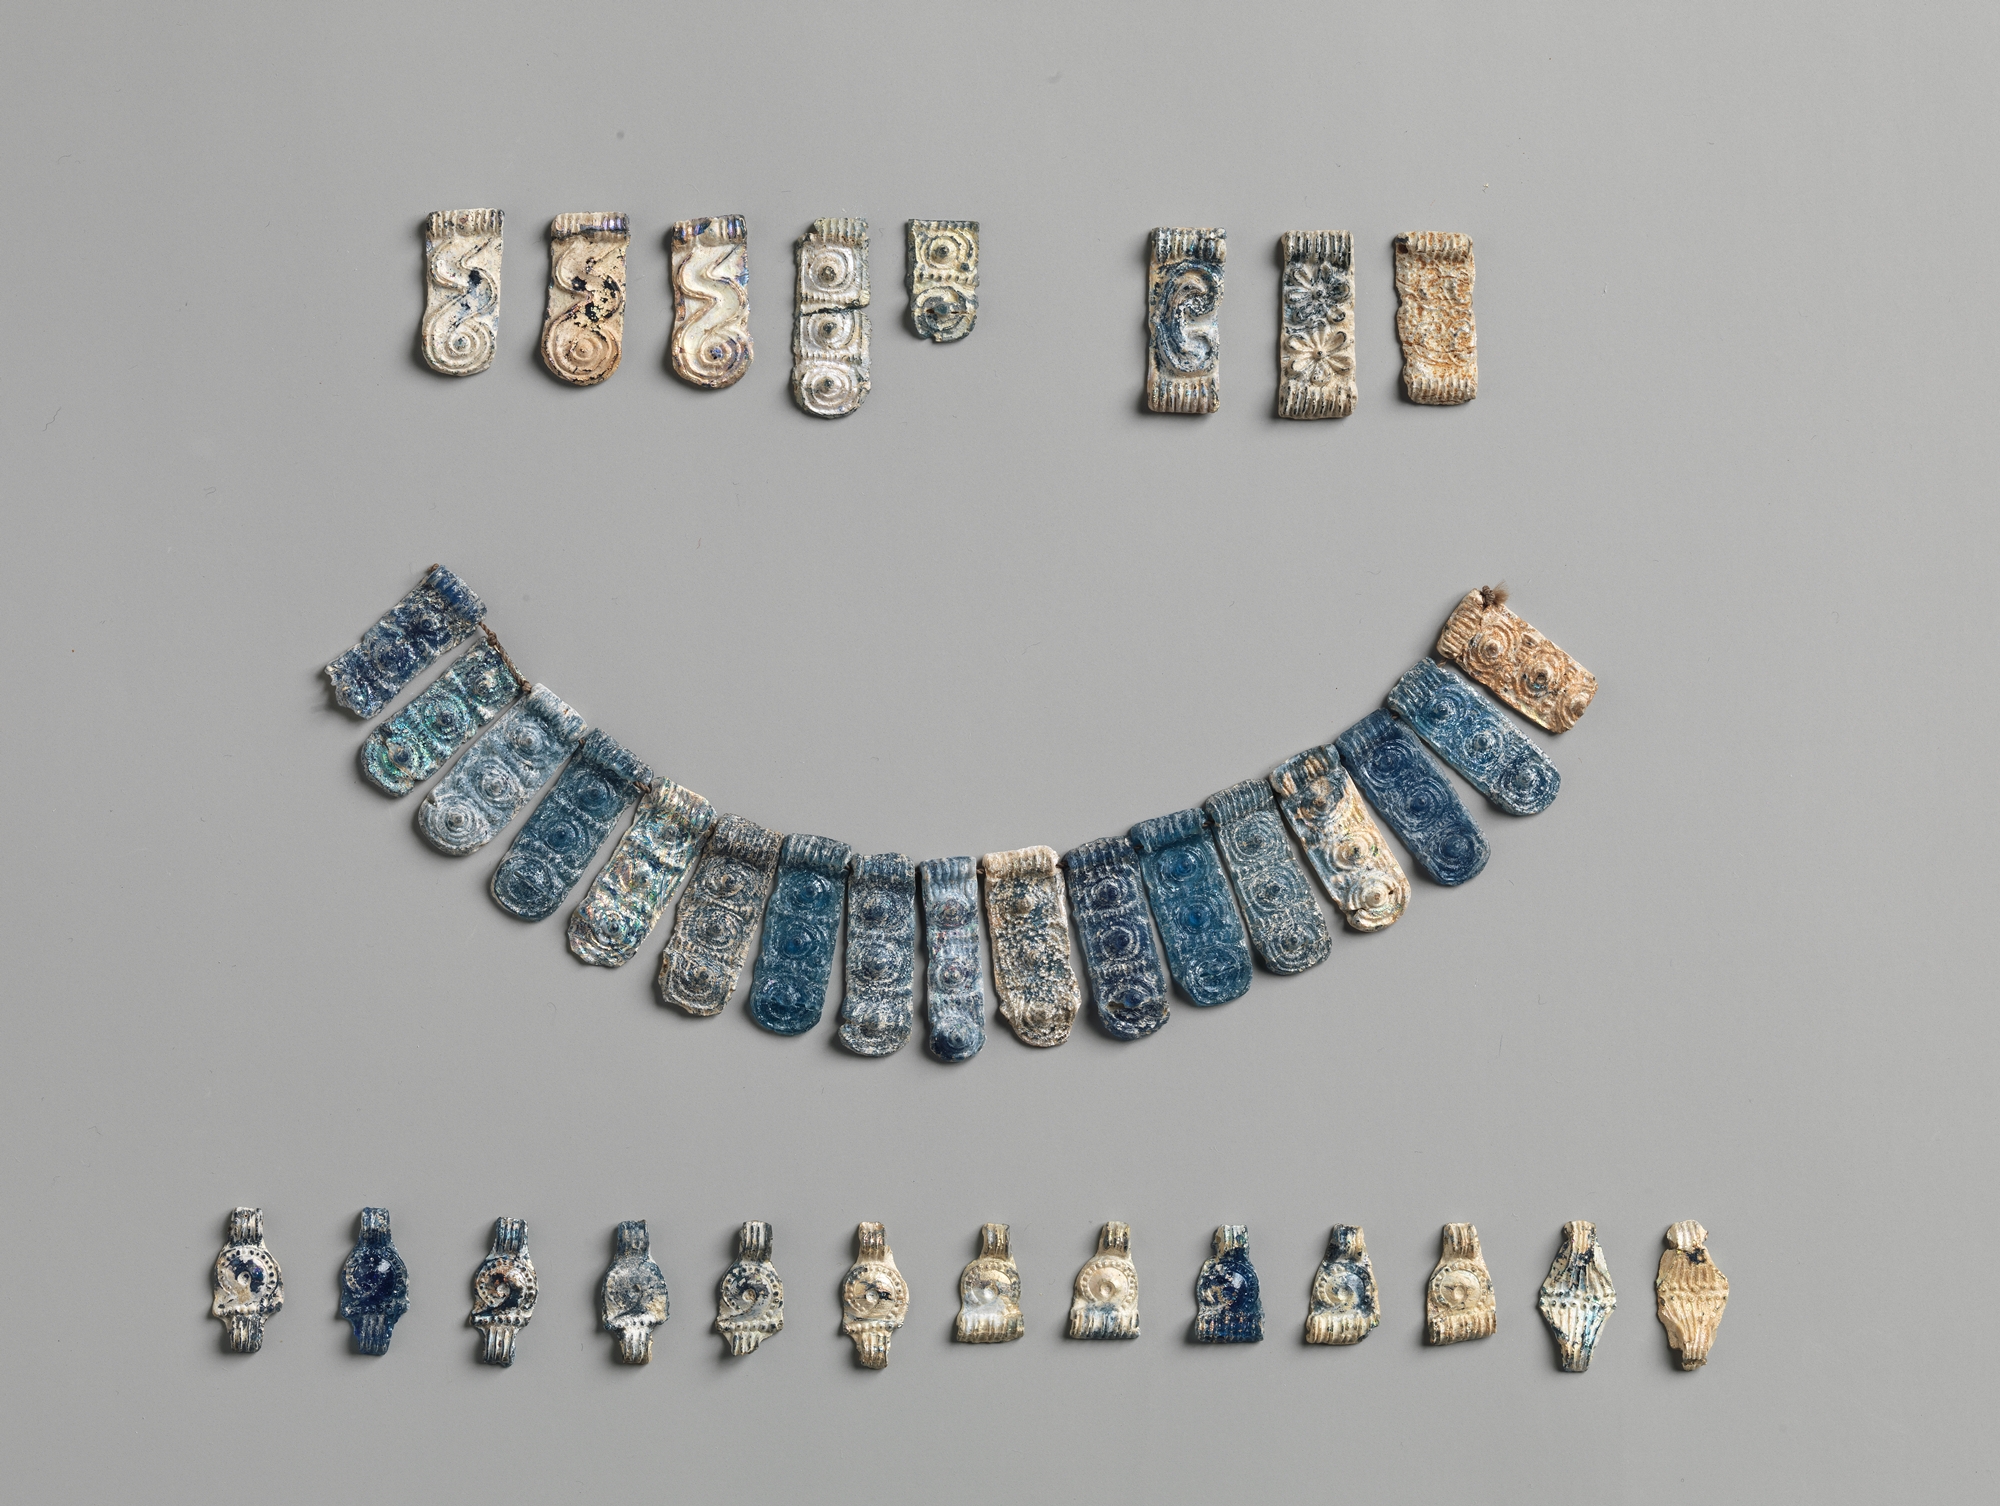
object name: ornament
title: Glass ornaments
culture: aegean, helladic or mycenaean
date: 1370-1200 BCE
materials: glass